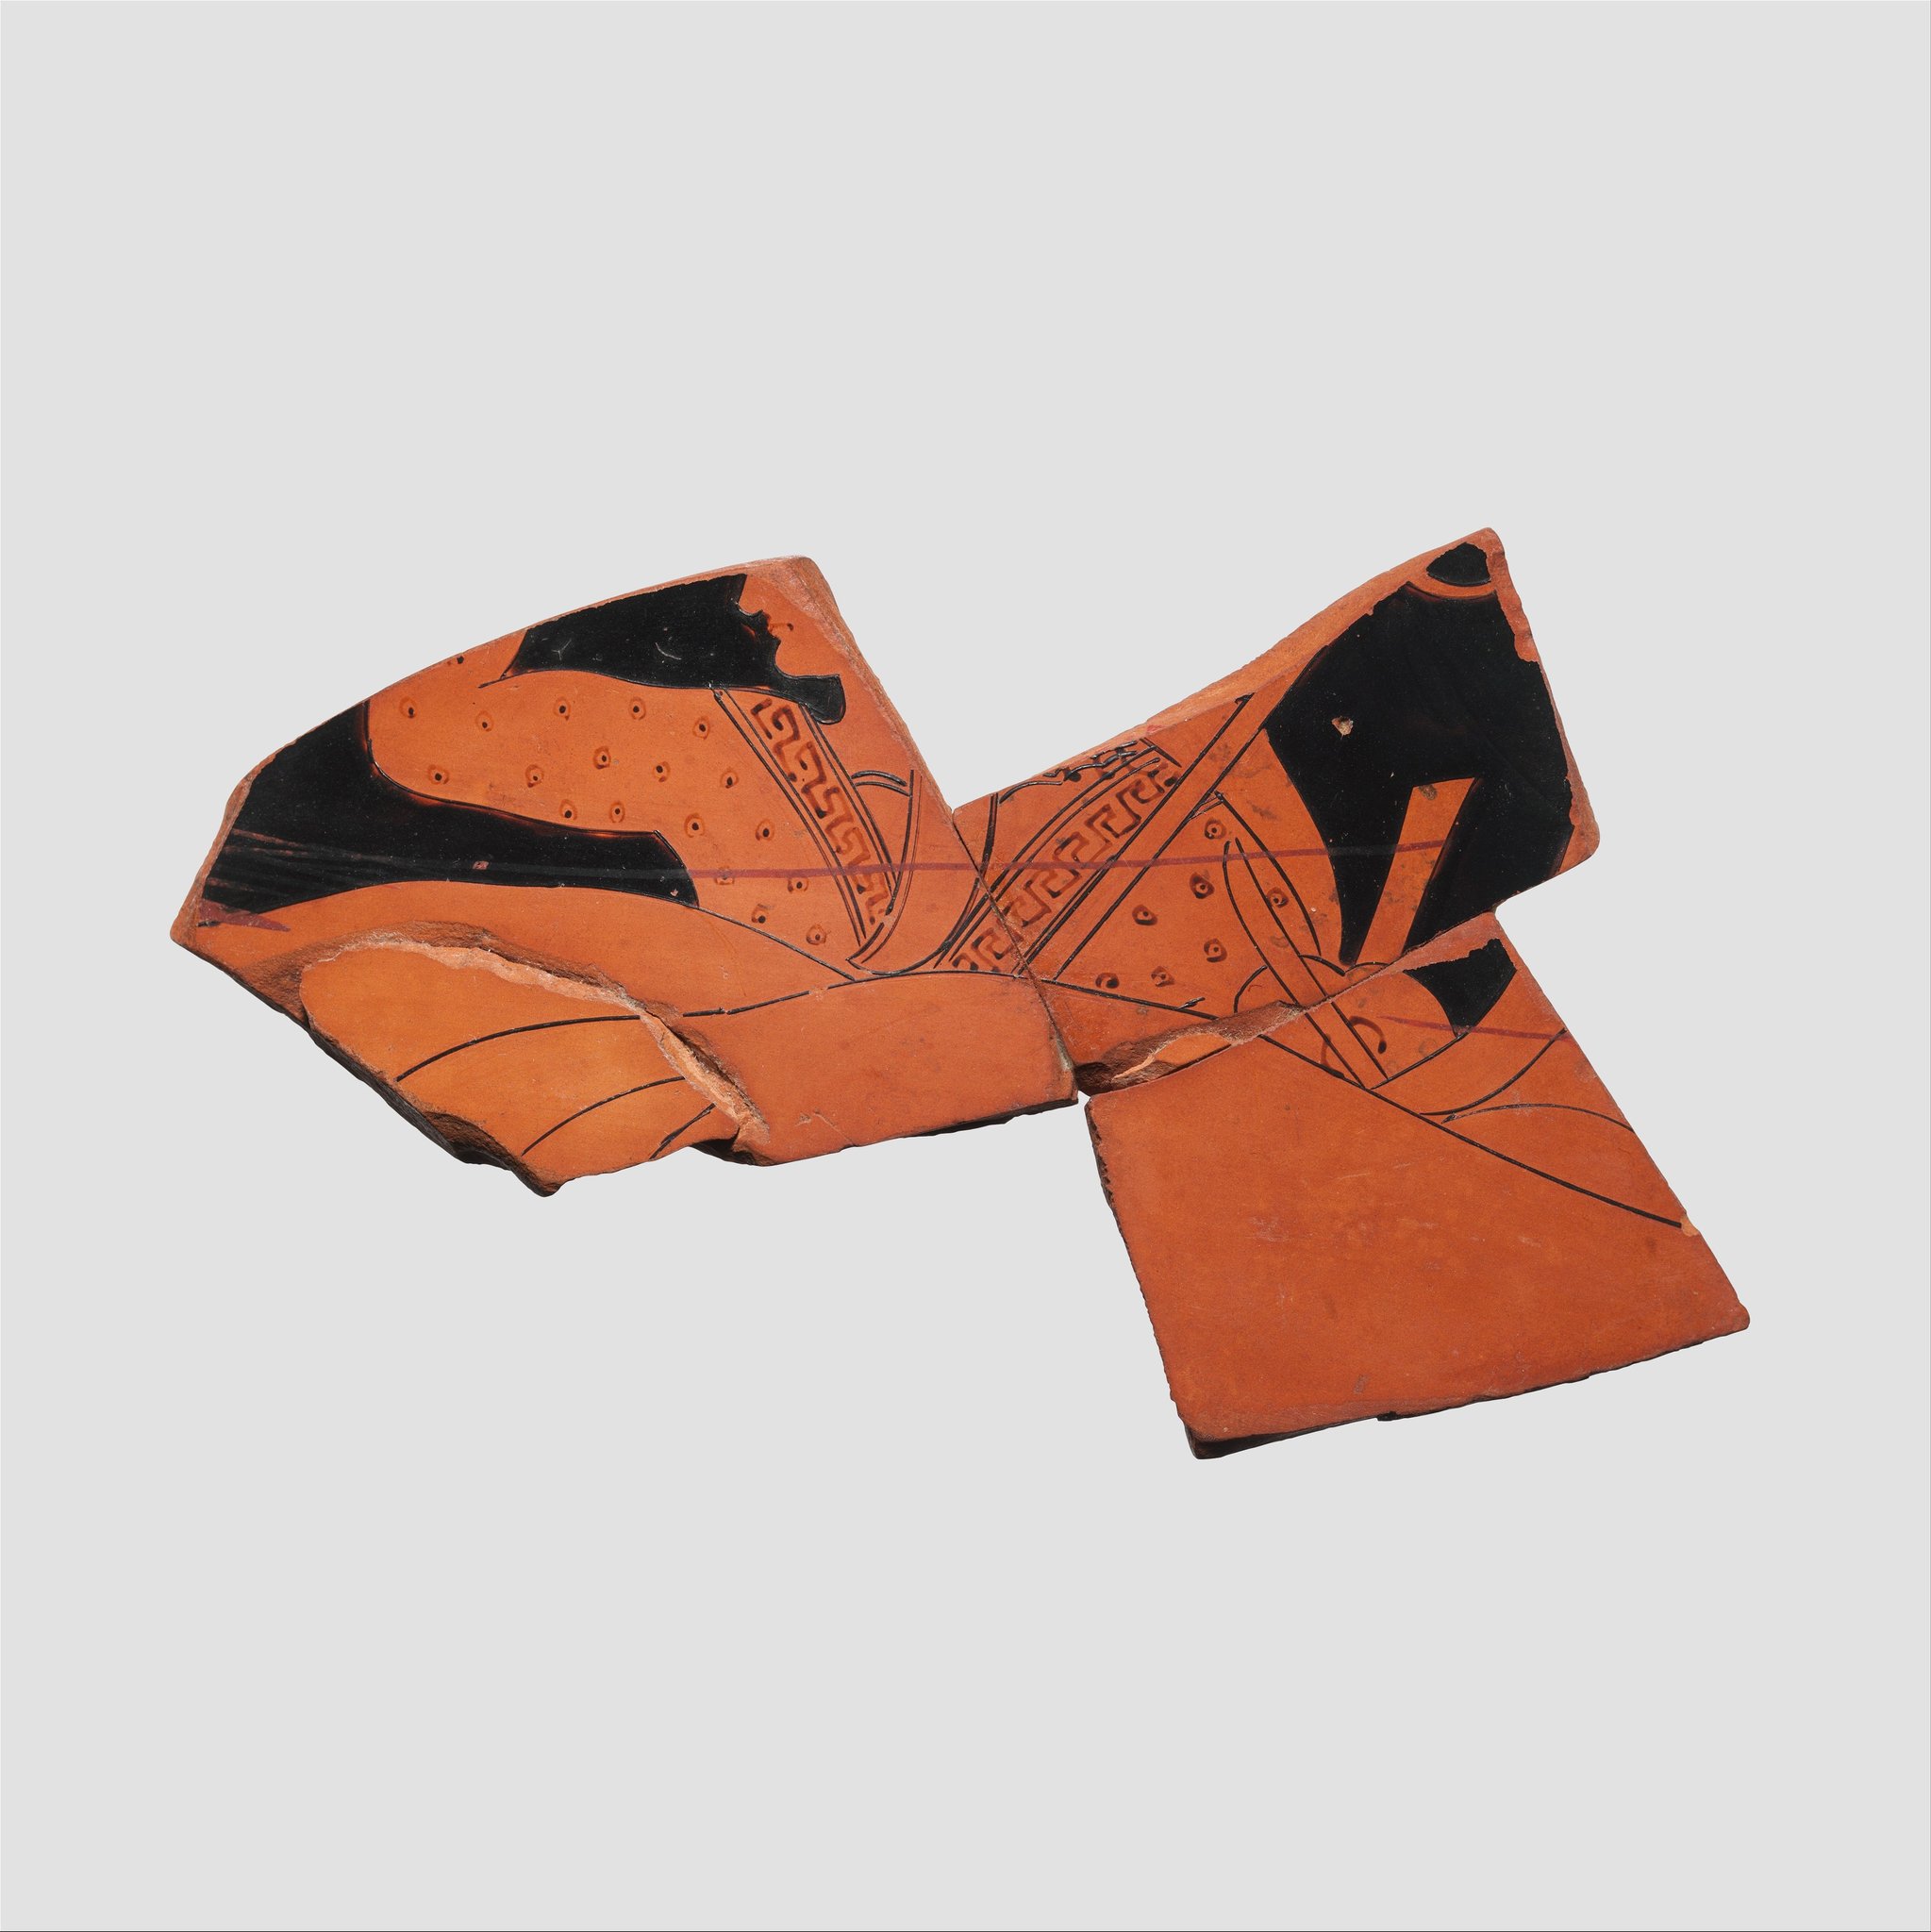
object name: calyx krater fragment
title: Two fragments of a terracotta calyx-krater (bowl for mixing wine and water)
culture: greek, attic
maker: pioneer group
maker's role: artist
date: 534-501 BCE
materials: terracotta